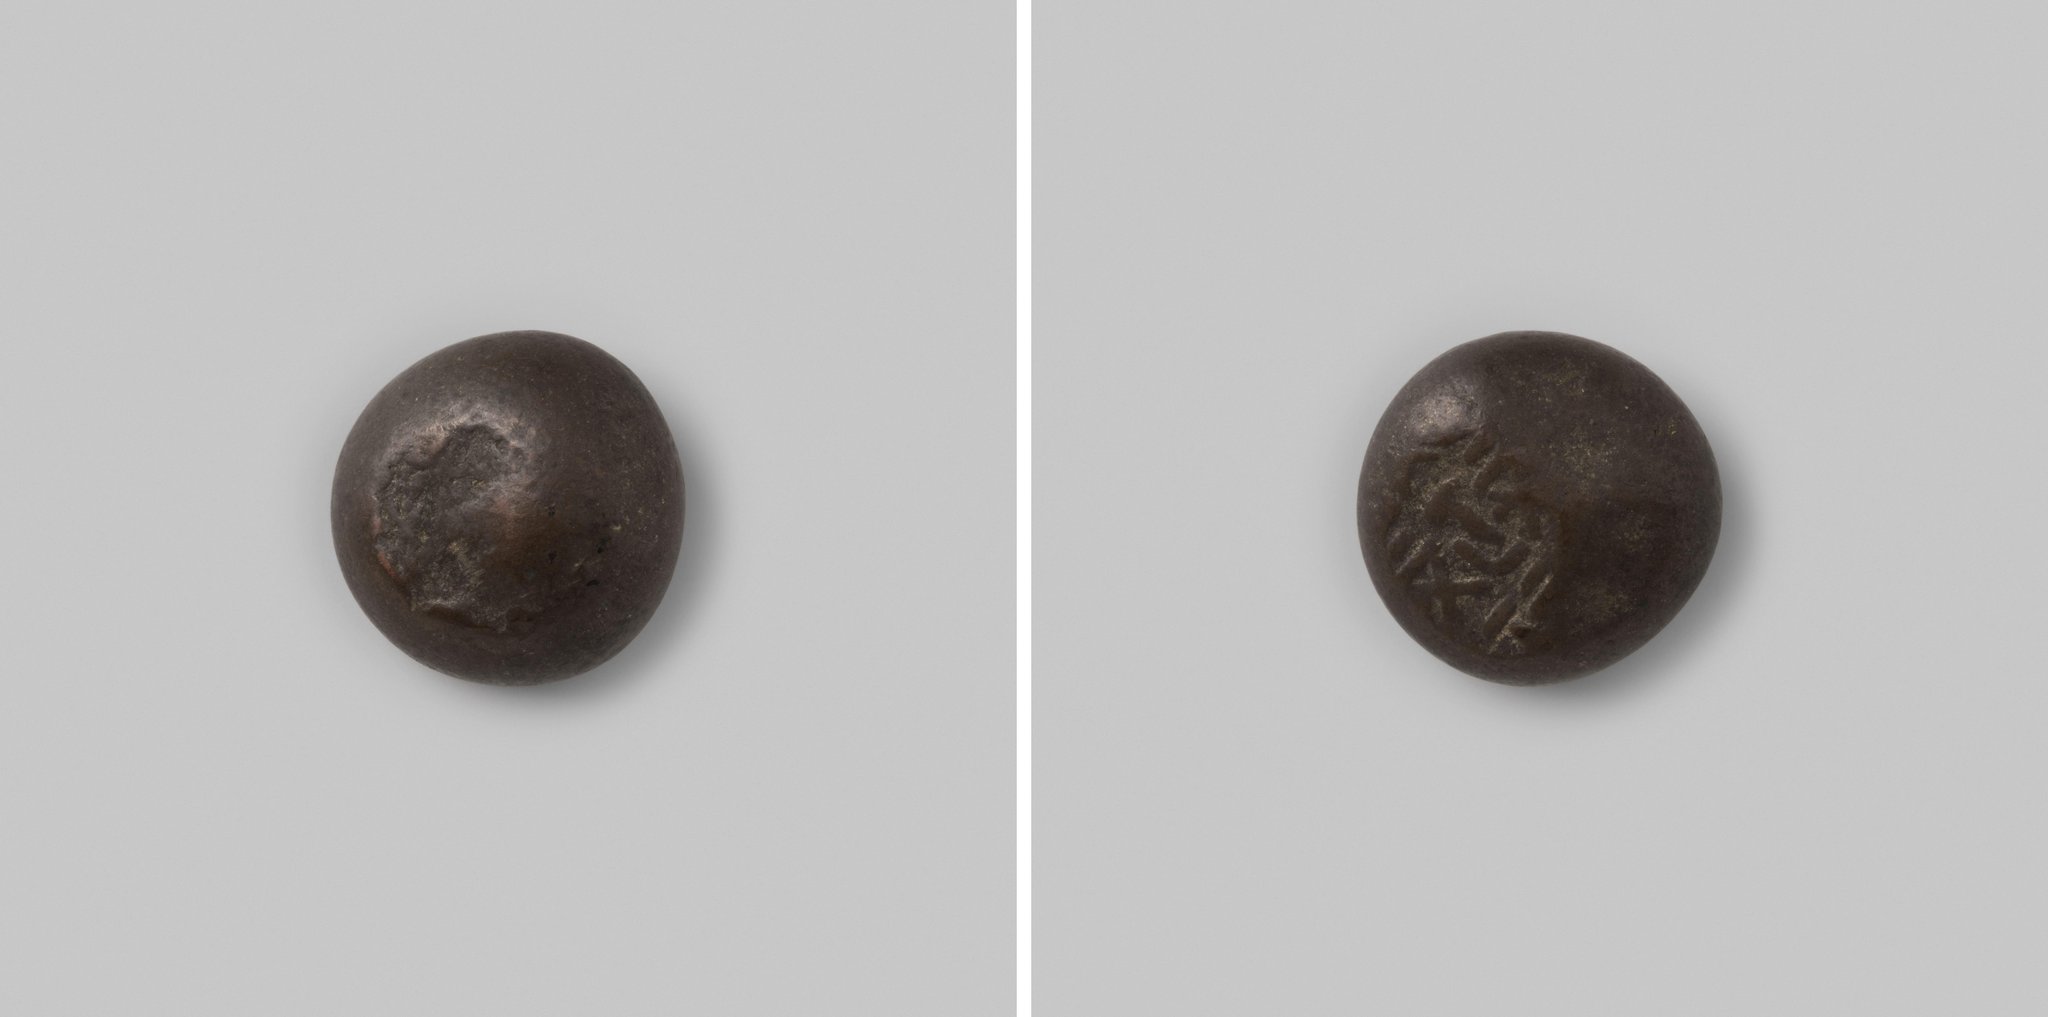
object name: coin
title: Mametita-gin [=zilveren boontje] van 1 bu het keizerrijk Japan, uit de 17e, 18e en 19e eeuw tot 1865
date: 1600-1865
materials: silver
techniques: striking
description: Zilveren langwerpige munt. Voorzijde: deel van een formele inscriptie met tijdperk-aanduiding: Of: "God van de Veelvuldigheid-symbool met op zijn buik tijdperk-aanduiding. Keerzijde: glad.